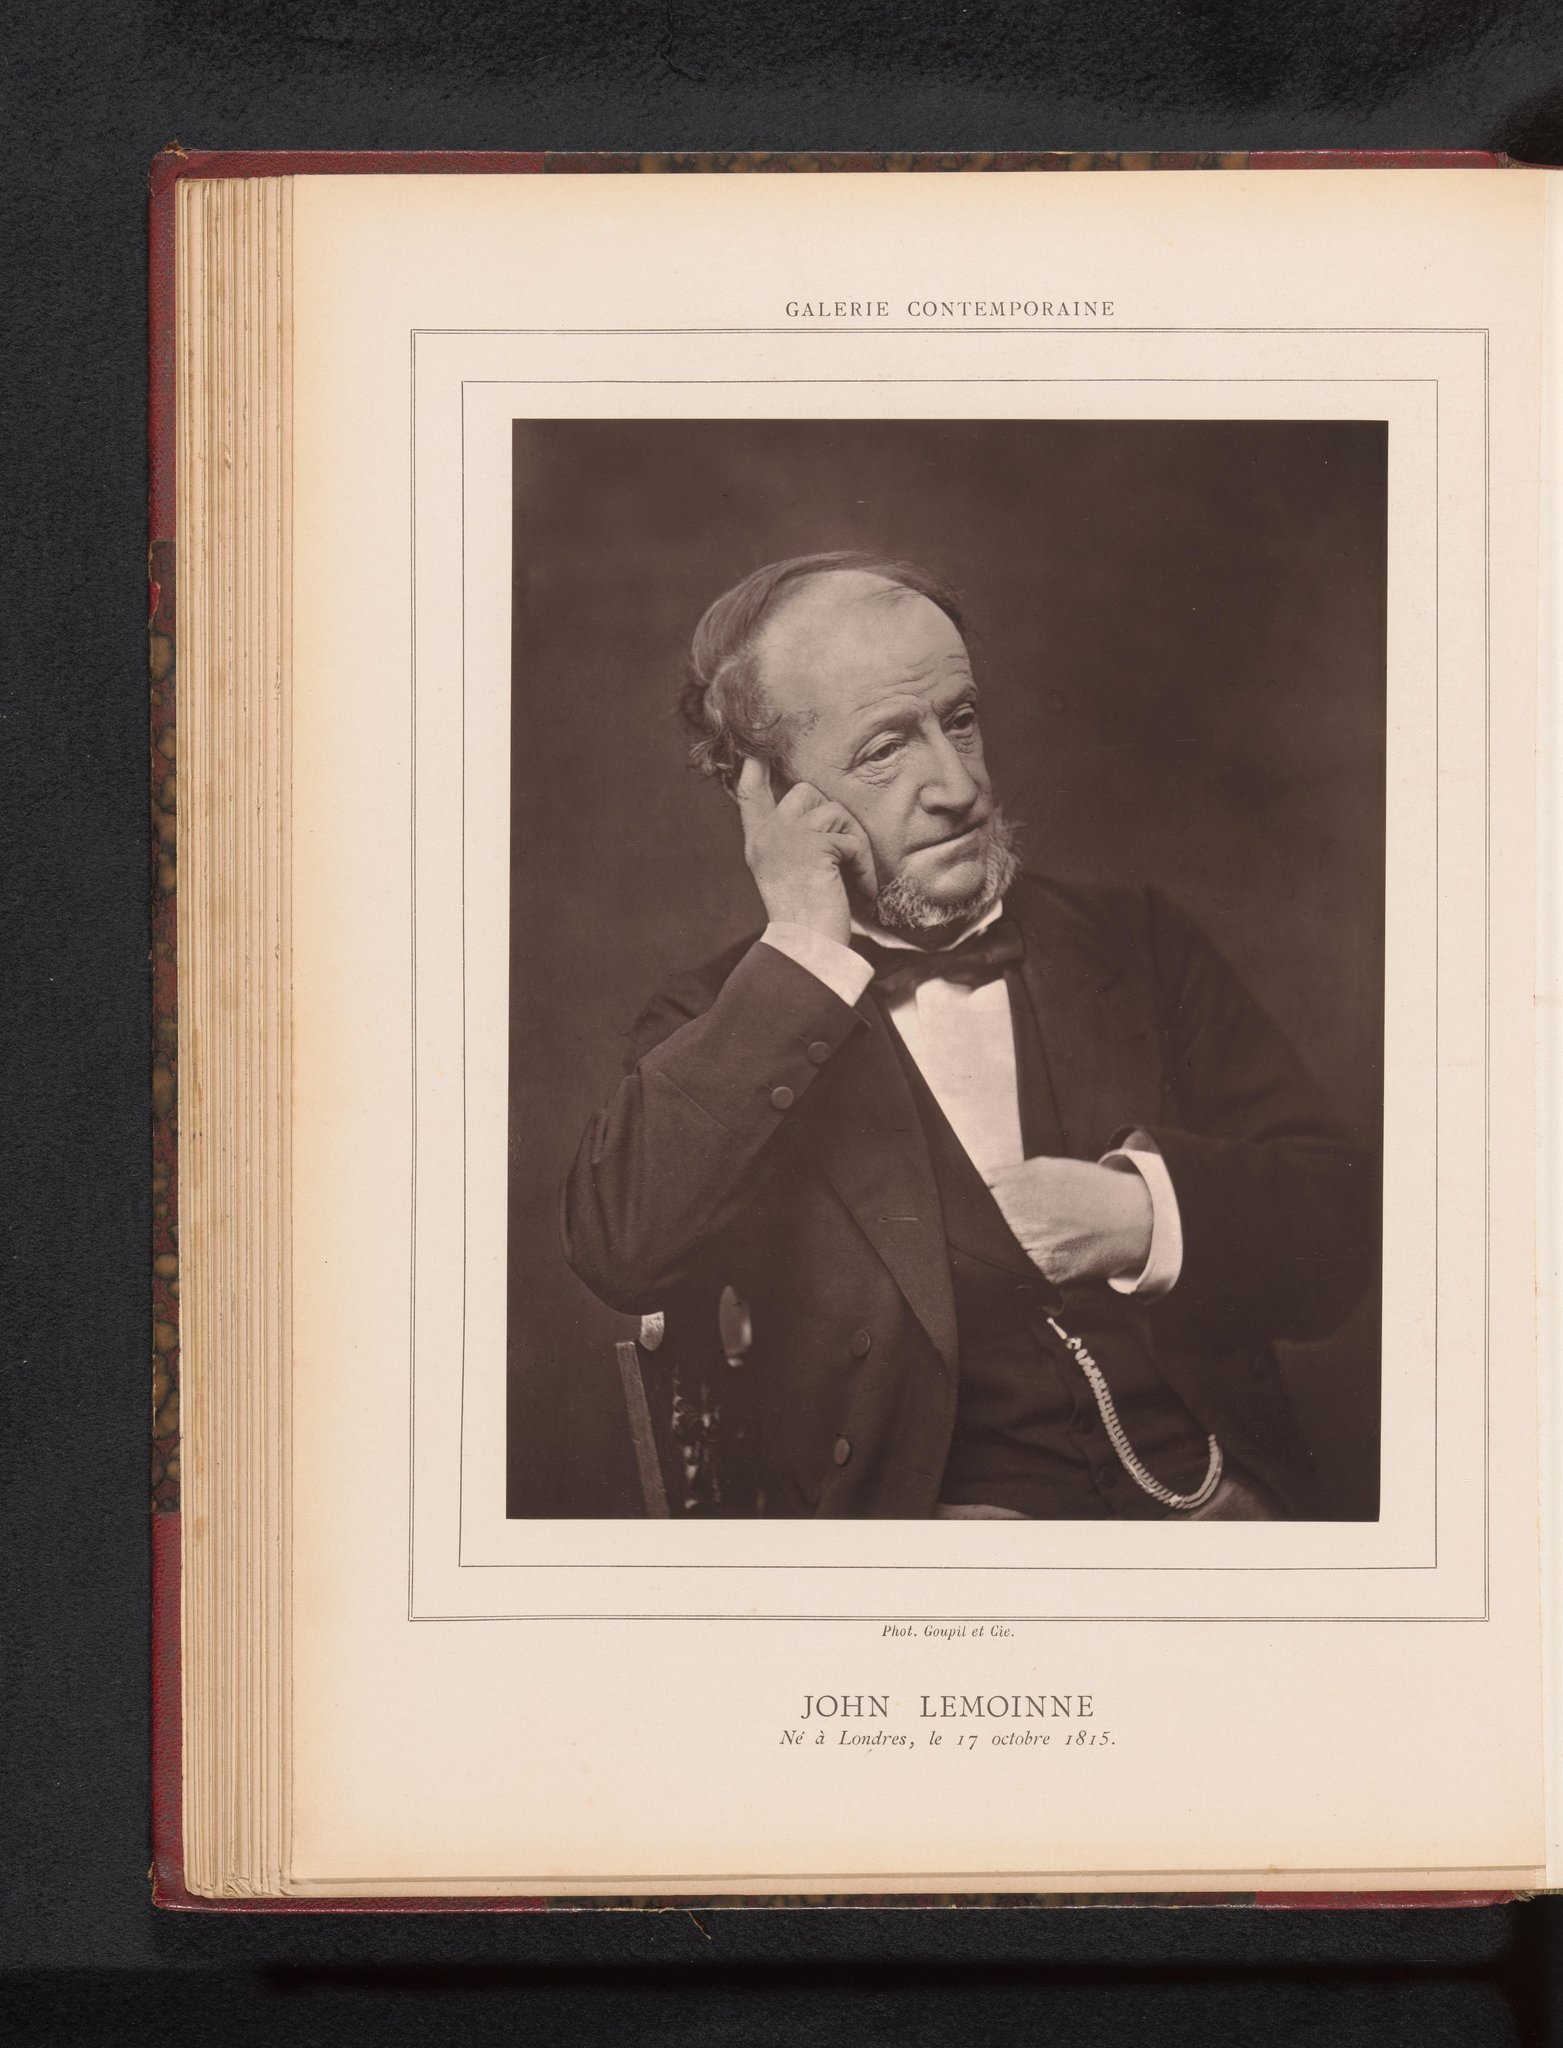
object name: photomechanical print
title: Portret van John Lemoinne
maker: Anonymous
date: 1867-1880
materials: paper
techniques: woodburytype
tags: london, paris, politician, adult man, historical persons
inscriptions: inscription: ‘Galerie Contemporaine/ Né a Londres, le 17 octobre 1815.’